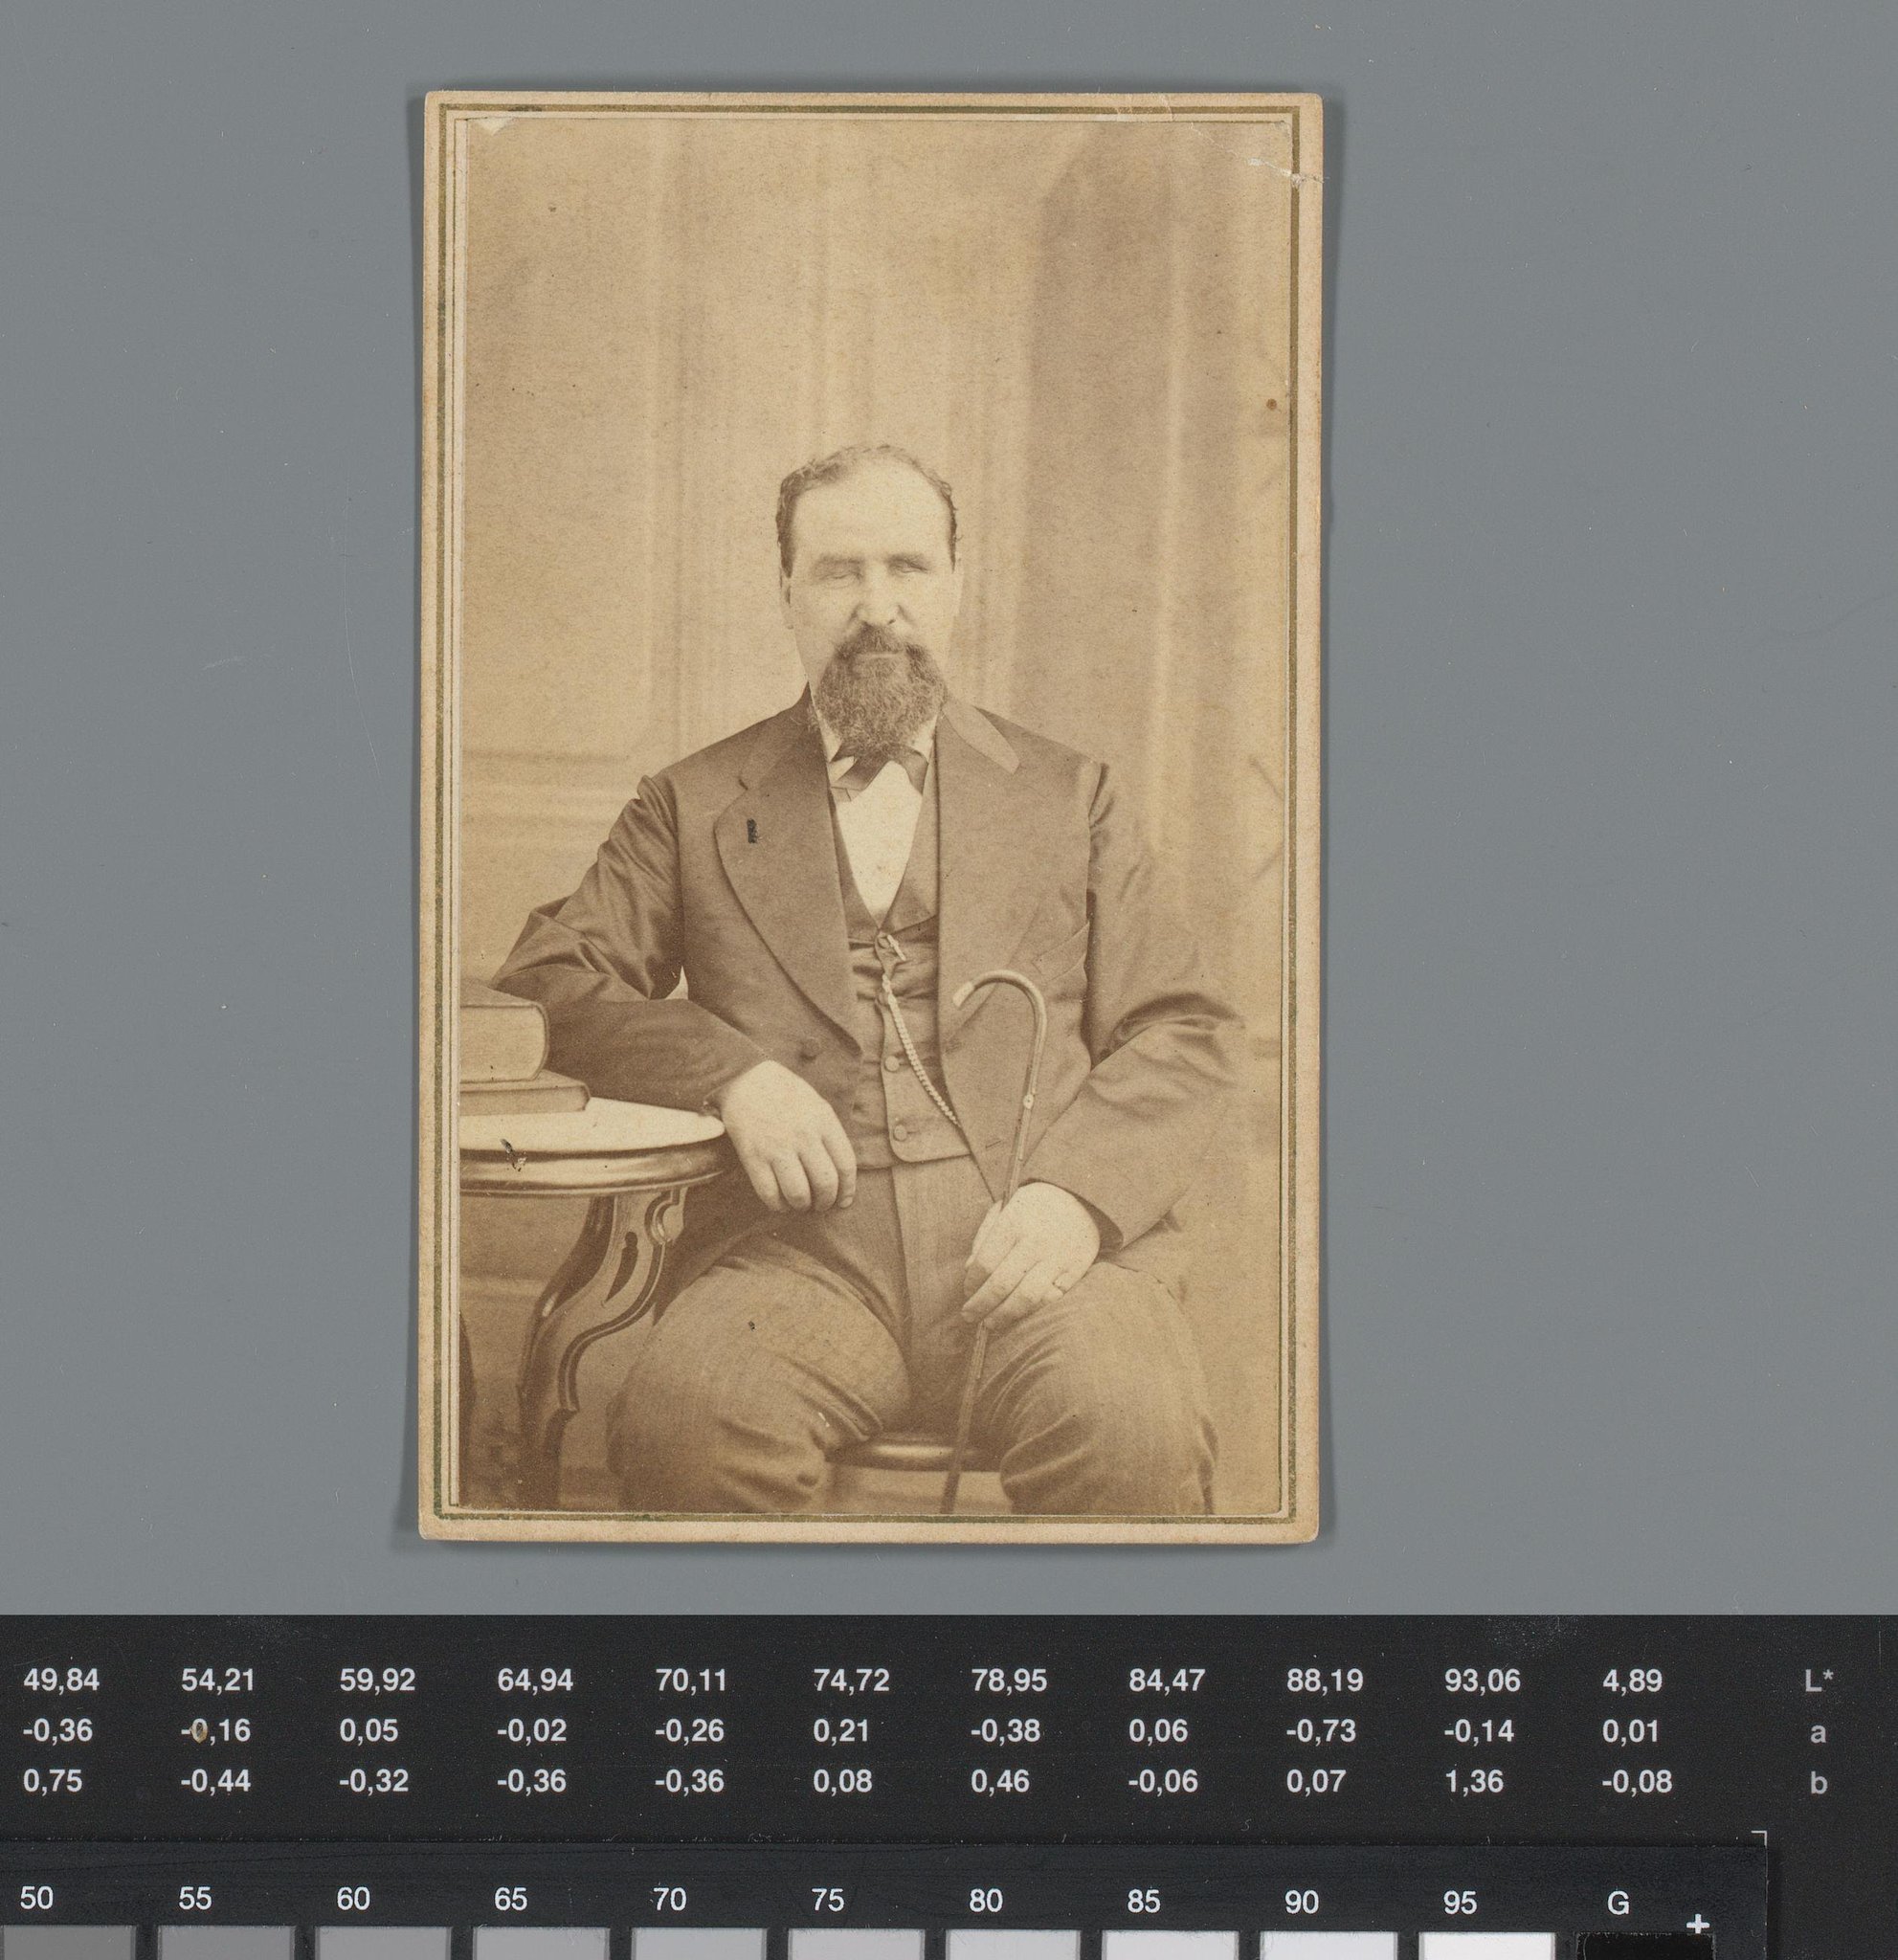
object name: carte de visite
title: Reclame voor geschenken van L.D. Sine te Cincinnati, met portret van L.D. Sine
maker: Anonymous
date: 1850-1915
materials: cardboard, photographic support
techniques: albumen print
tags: advertising, historical persons, blind, blindness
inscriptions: inscription: ‘L. D. SINE. / The above named gentleman is well known as the pioneer of Gift Enterprises. (...) Cincinnati.’